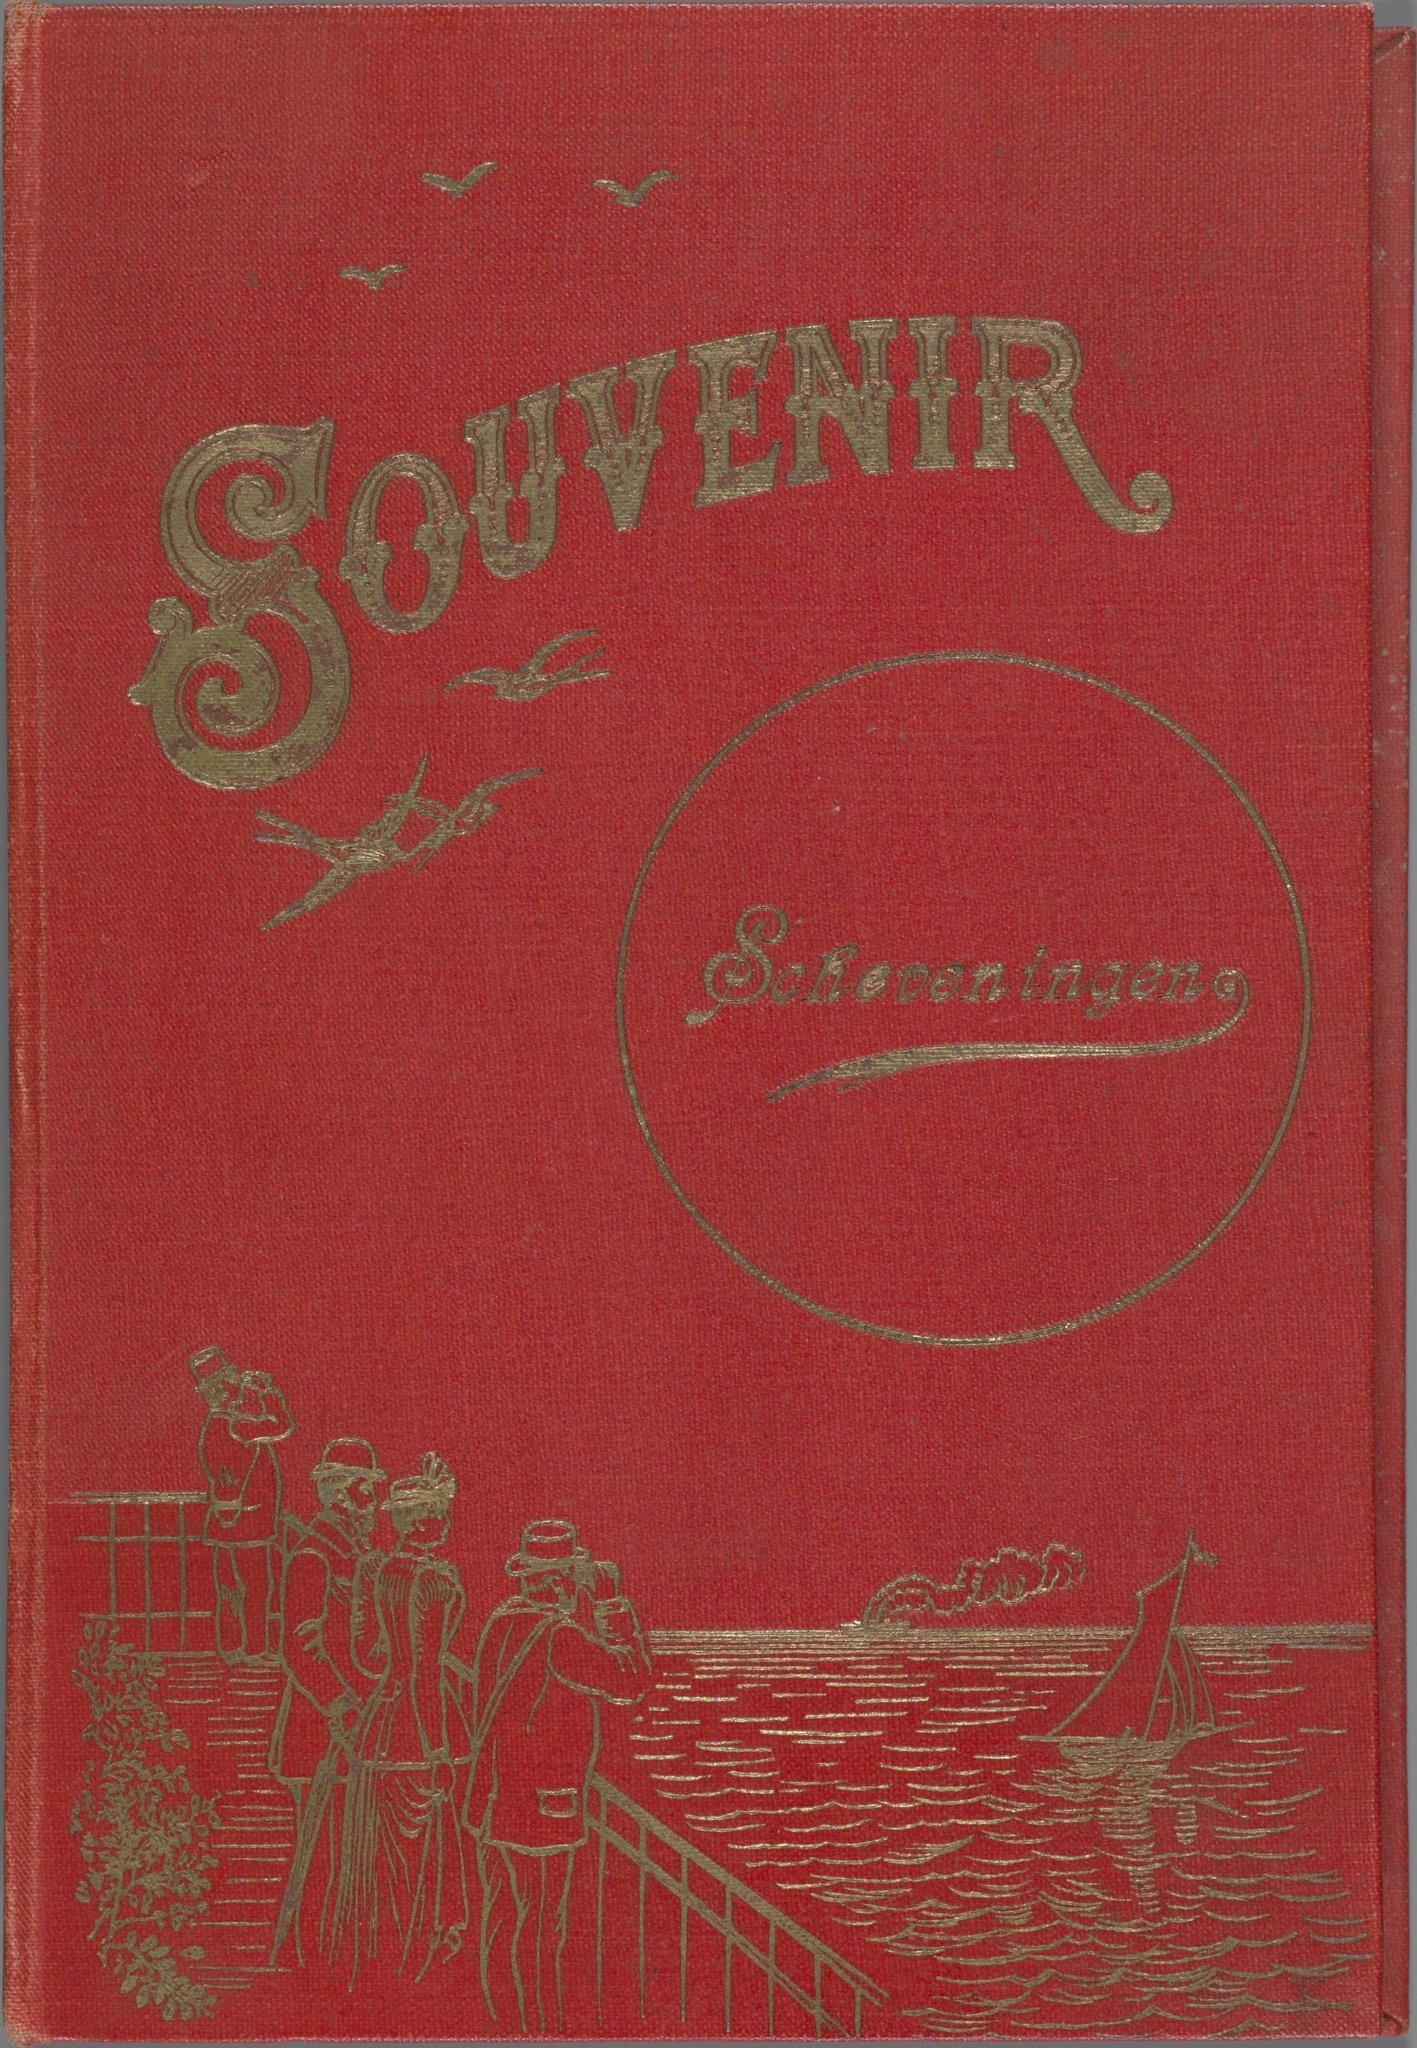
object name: accordion book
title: Leporelloalbum met opnames van Scheveningen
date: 1890-1910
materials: cardboard, linen, paper, photographic support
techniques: photograph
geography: scheveningen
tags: prospect of village, silhouette of village, travelling; tourism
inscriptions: name: ‘Magasin au bon marché H. Fuld Kurhaus Galerie 11.12.13. Scheveningue’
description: Leporelloalbum in rode linnen band met op de voorzijde in gouddruk de titel en een strandtafereel. Het album bevat twaalf aan elkaar vastzittende, uitklapbare kabinetfoto's. Het zijn lichtdrukken van Scheveningen: het Kurhaus, strandgezichten, vissersschepen, een havengezicht en een panorama. Ook een opname van de Hofvijver en het Binnenhof in Den Haag.